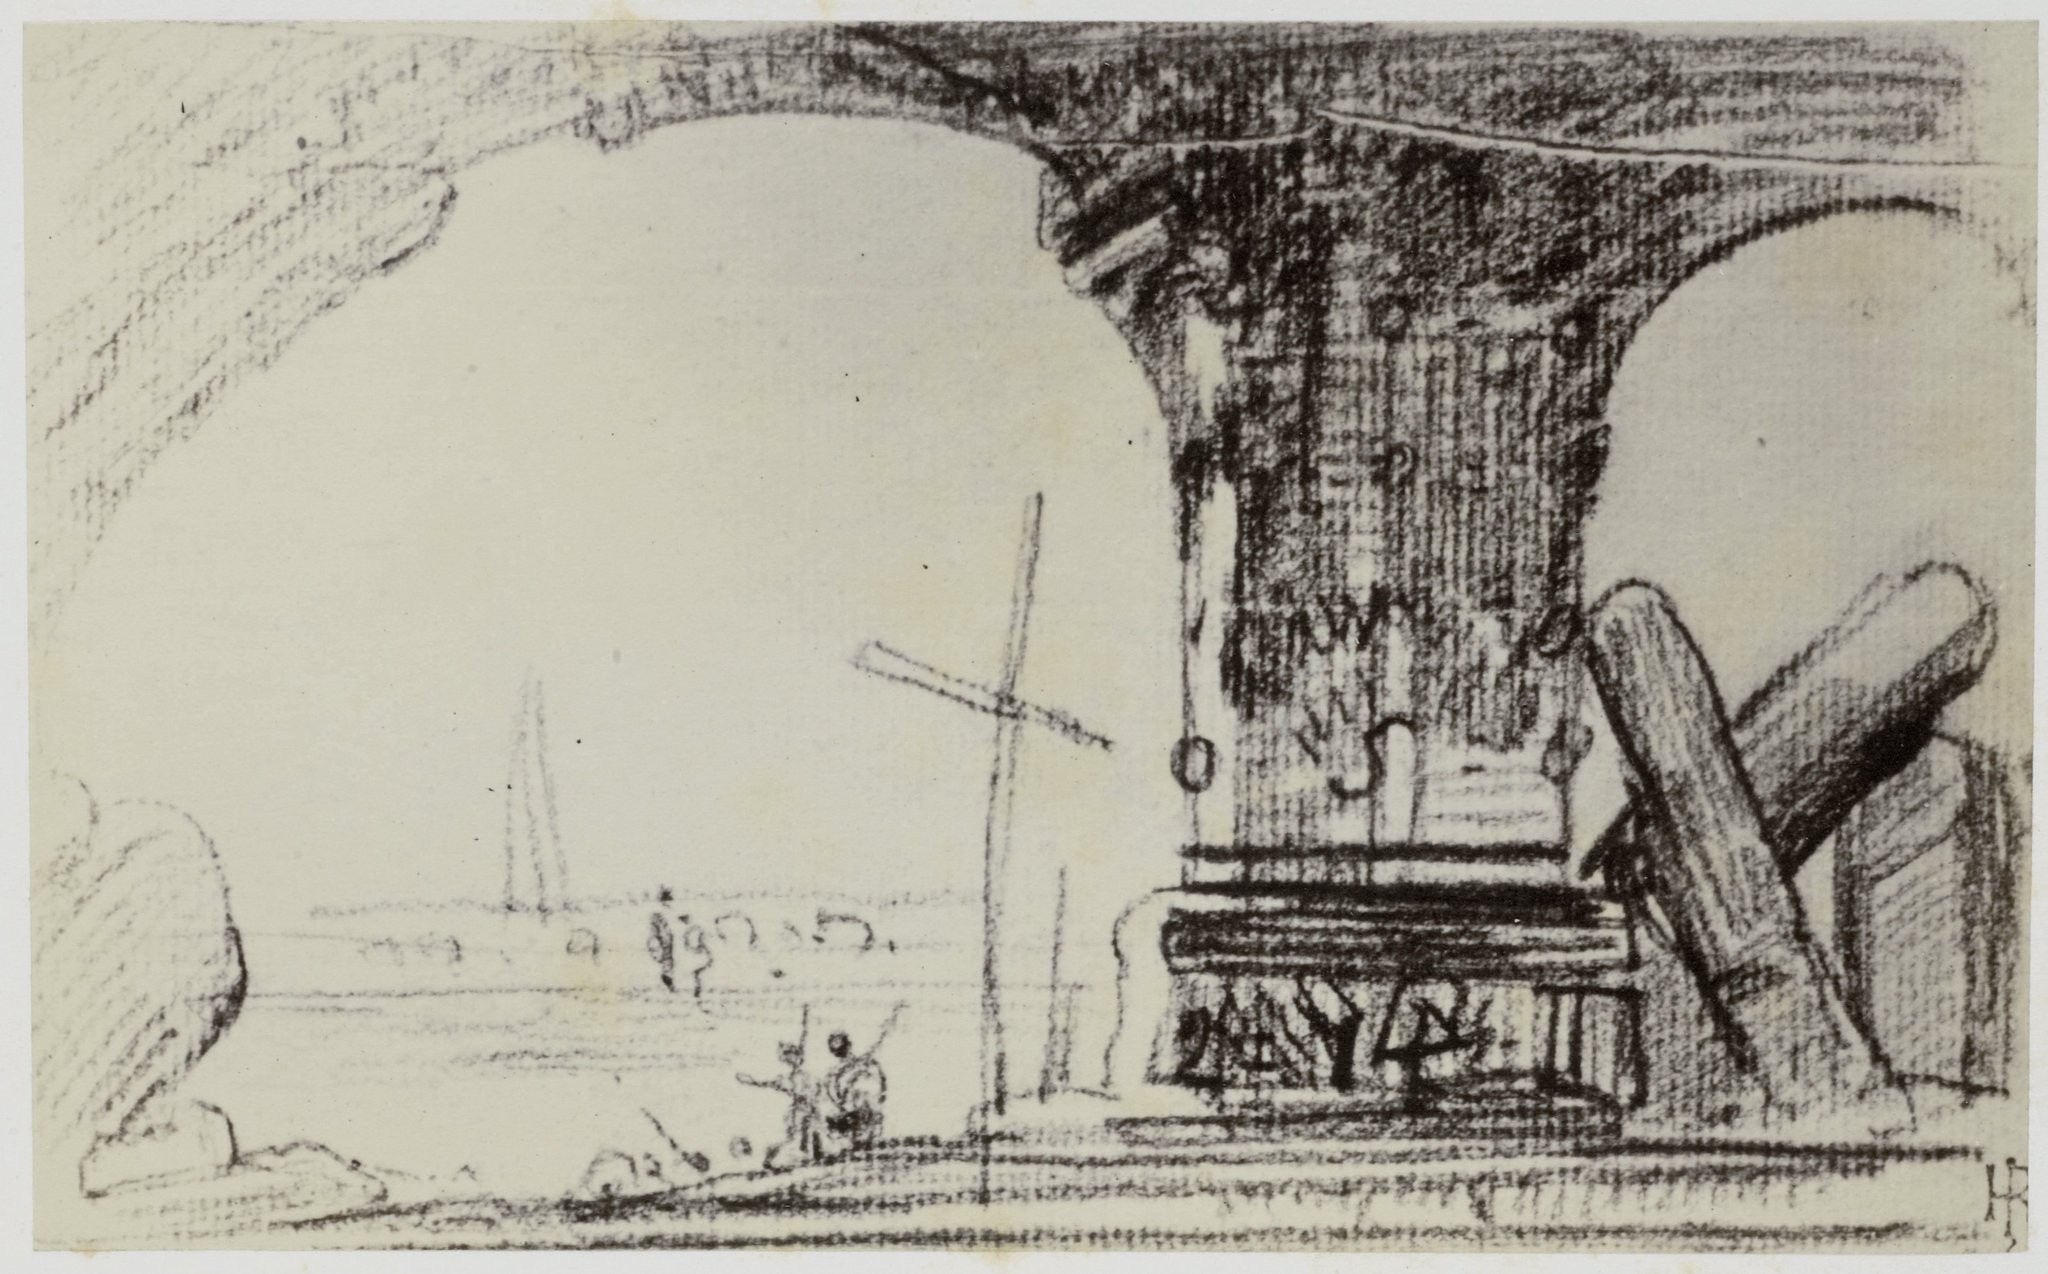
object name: photograph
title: Wilson, A Sketch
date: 1855-1858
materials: cardboard, paper, photographic support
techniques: albumen print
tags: drawing, sketch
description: Fotoreproductie van tekening in 'The Reveley Collection of Drawings at Brynygwin', afb. 58.